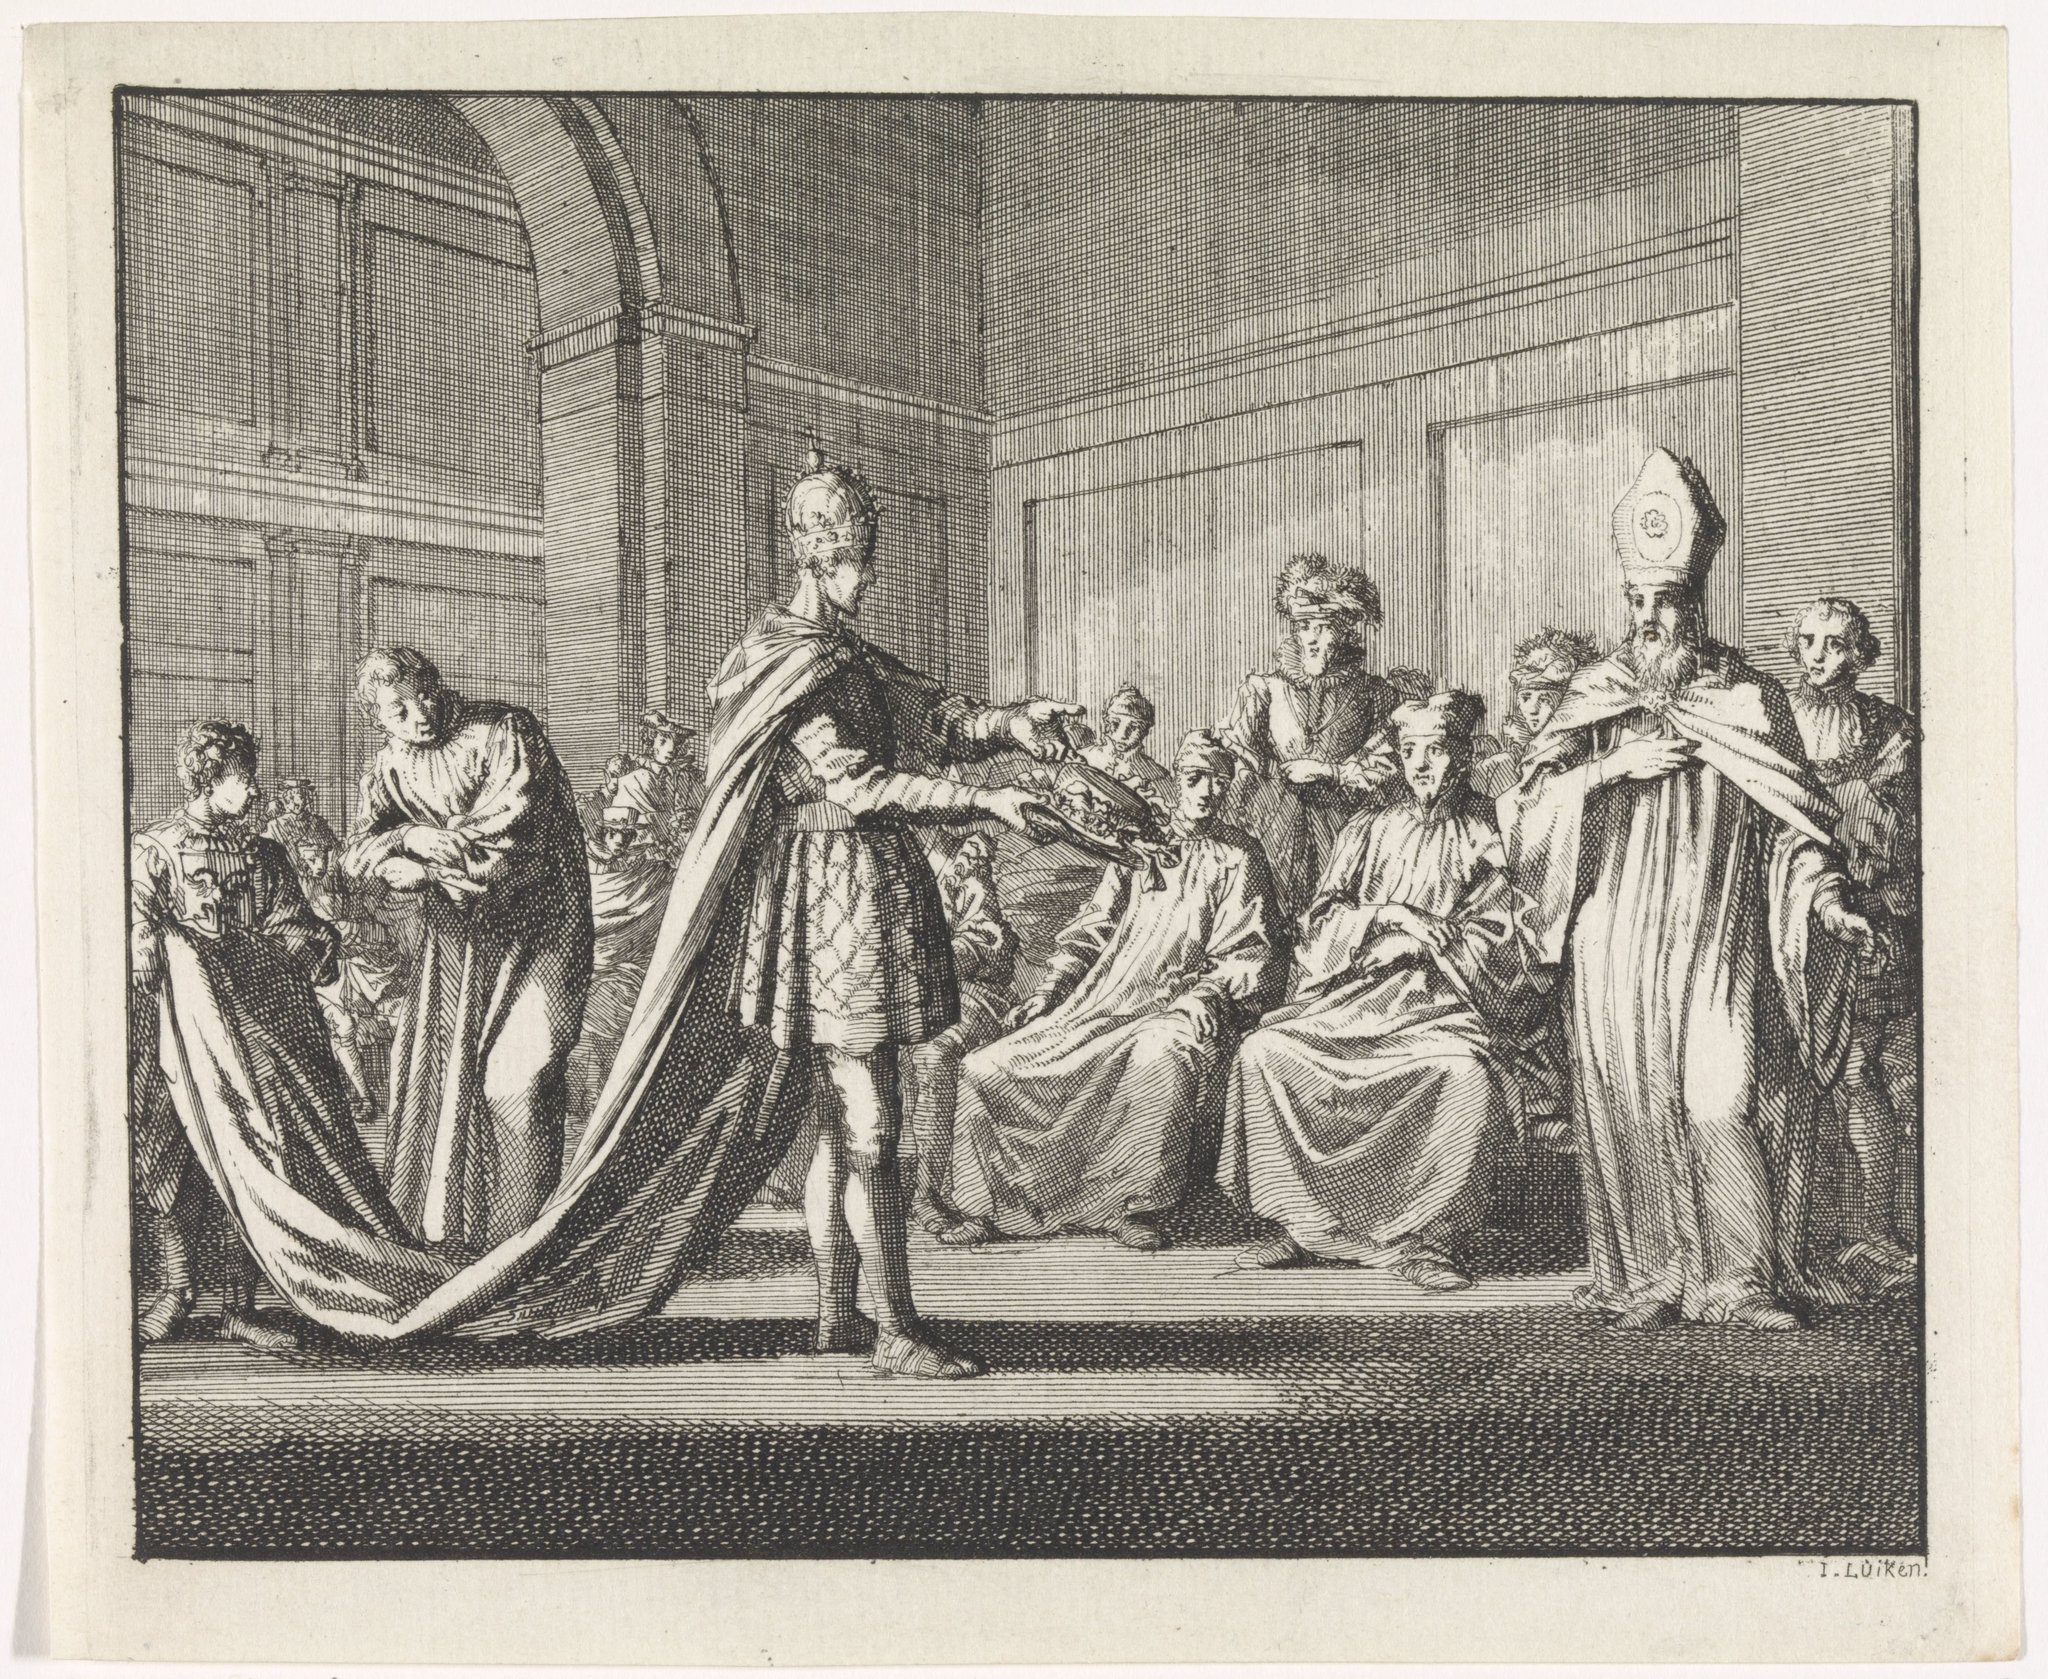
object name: print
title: De keizer confronteert de aartsbisschop met de weelde van de kerk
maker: jan luyken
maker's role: draughtsman, print maker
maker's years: 1649-1712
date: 1701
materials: paper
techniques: etching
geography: amsterdam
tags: the early christian churches, e.g. armenians, copts, syrians, archbishop, bishop, etc. (roman catholic), head-gear: hat (+ men's clothes), emperor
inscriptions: collector's mark: Lugt 2228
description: De Duitse keizer staat voor een aartsbisschop met in zijn handen een rijkelijk versierde hoed. Hij wijst er naar en confronteert de aanwezige geestelijken met de rijkdom en weelde van de kerk.